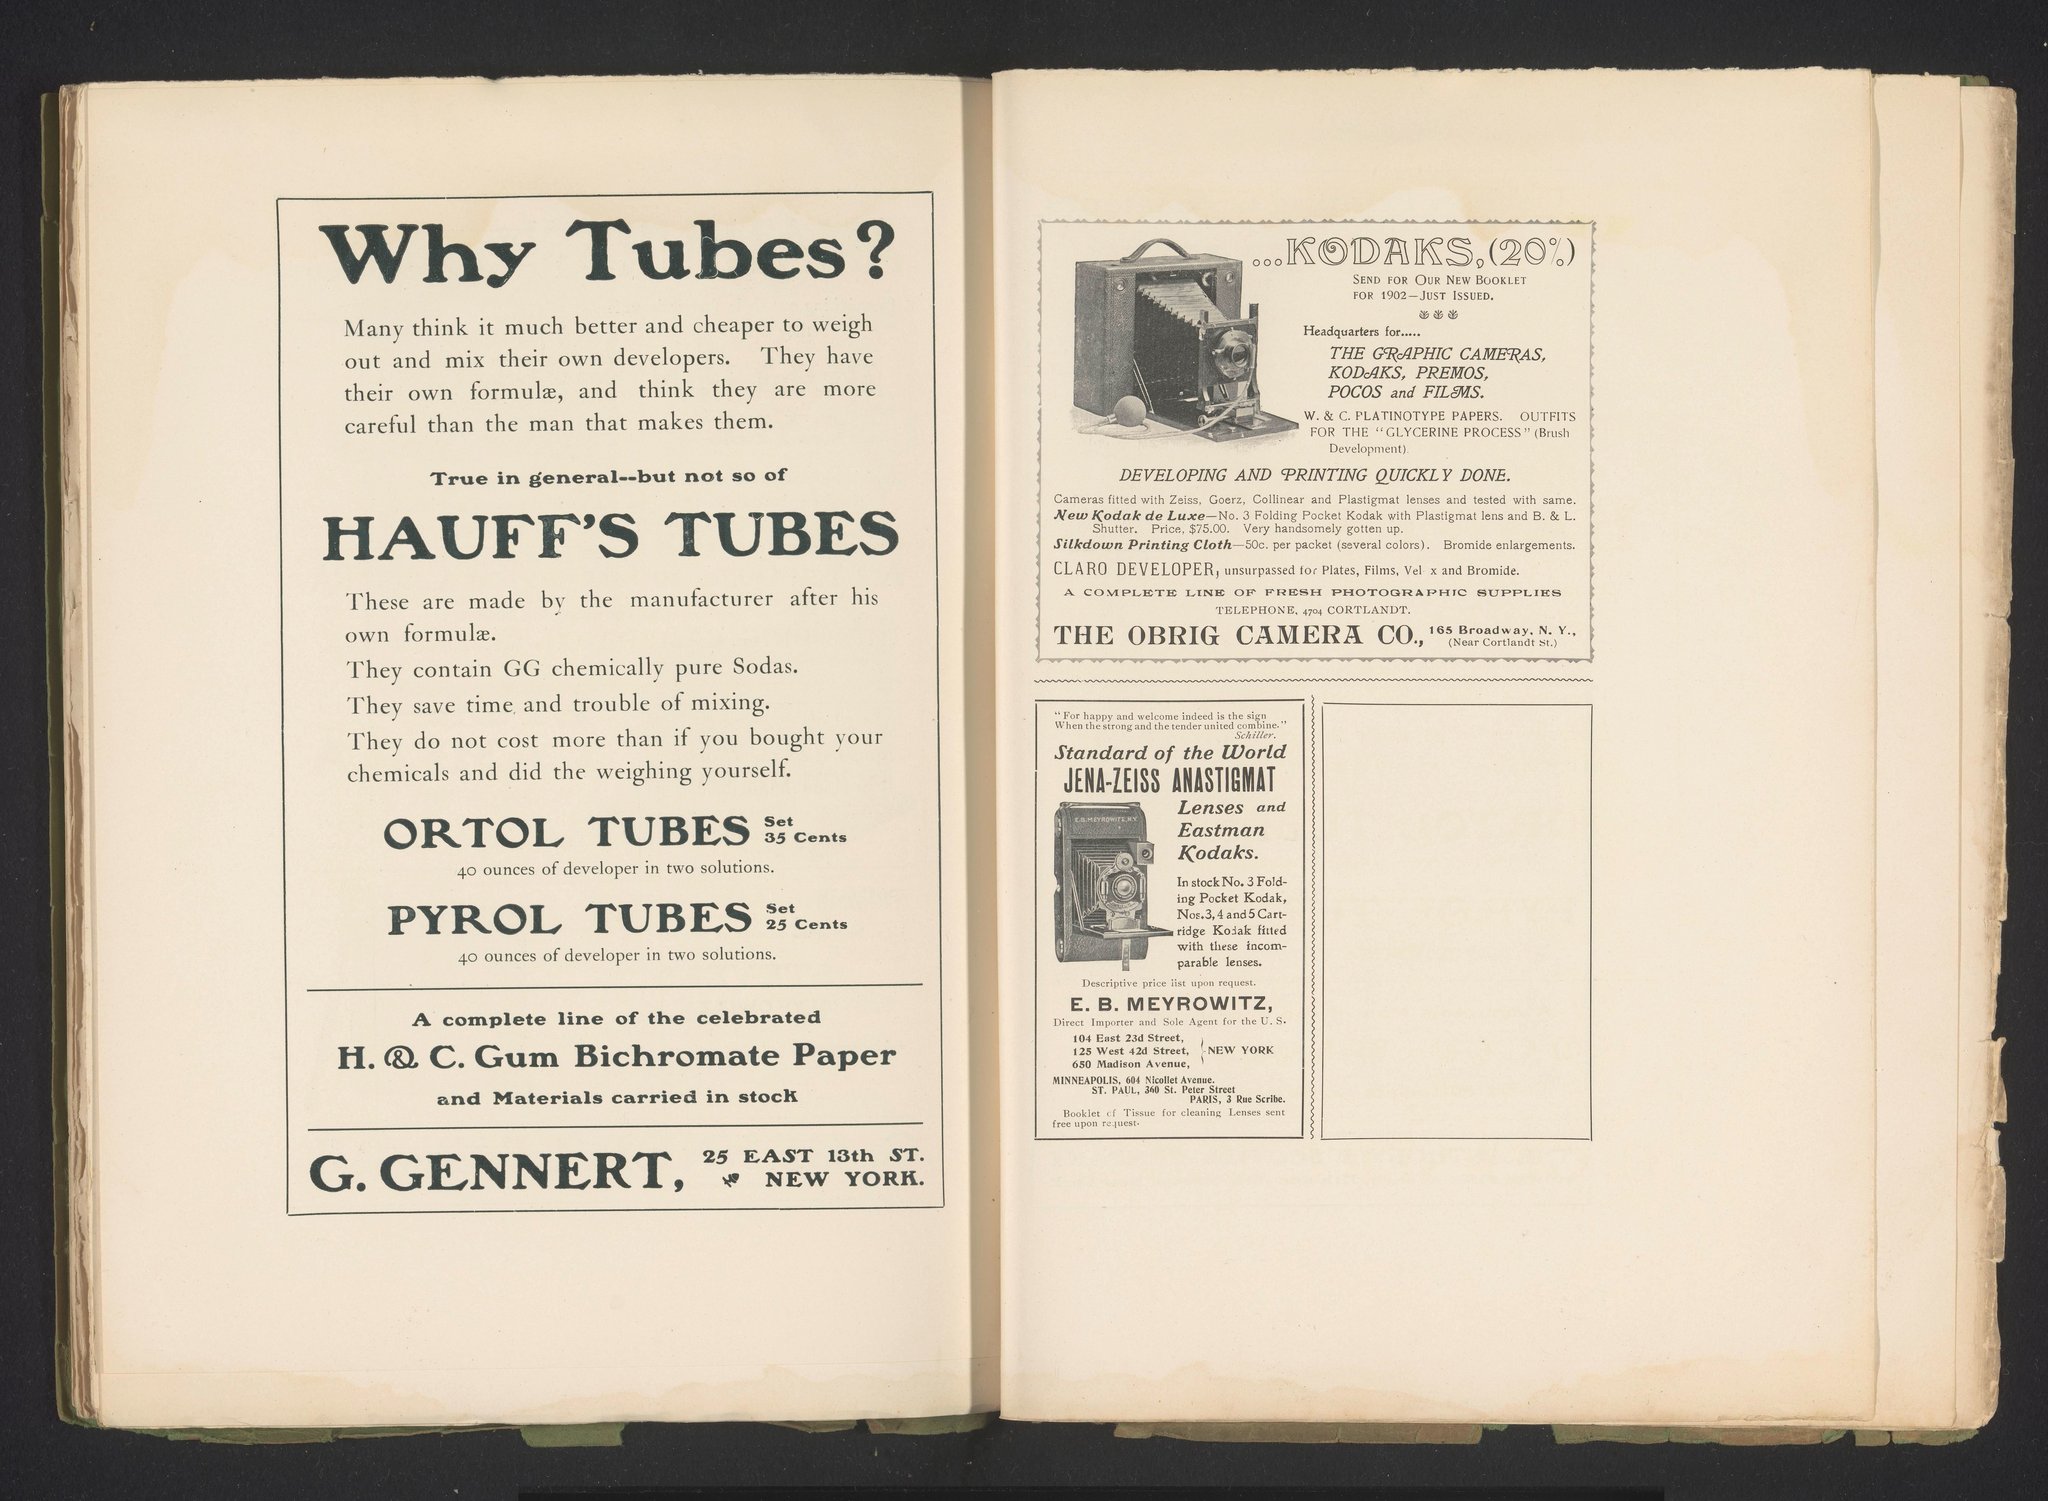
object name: photomechanical print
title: Kodak camera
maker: Anonymous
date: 1897-1902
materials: paper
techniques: autotype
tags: camera ~ photography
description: Prent in katern advertenties achterin boek. Prent is onderdeel van een reclameboodschap van E. B. Meyrowitz.